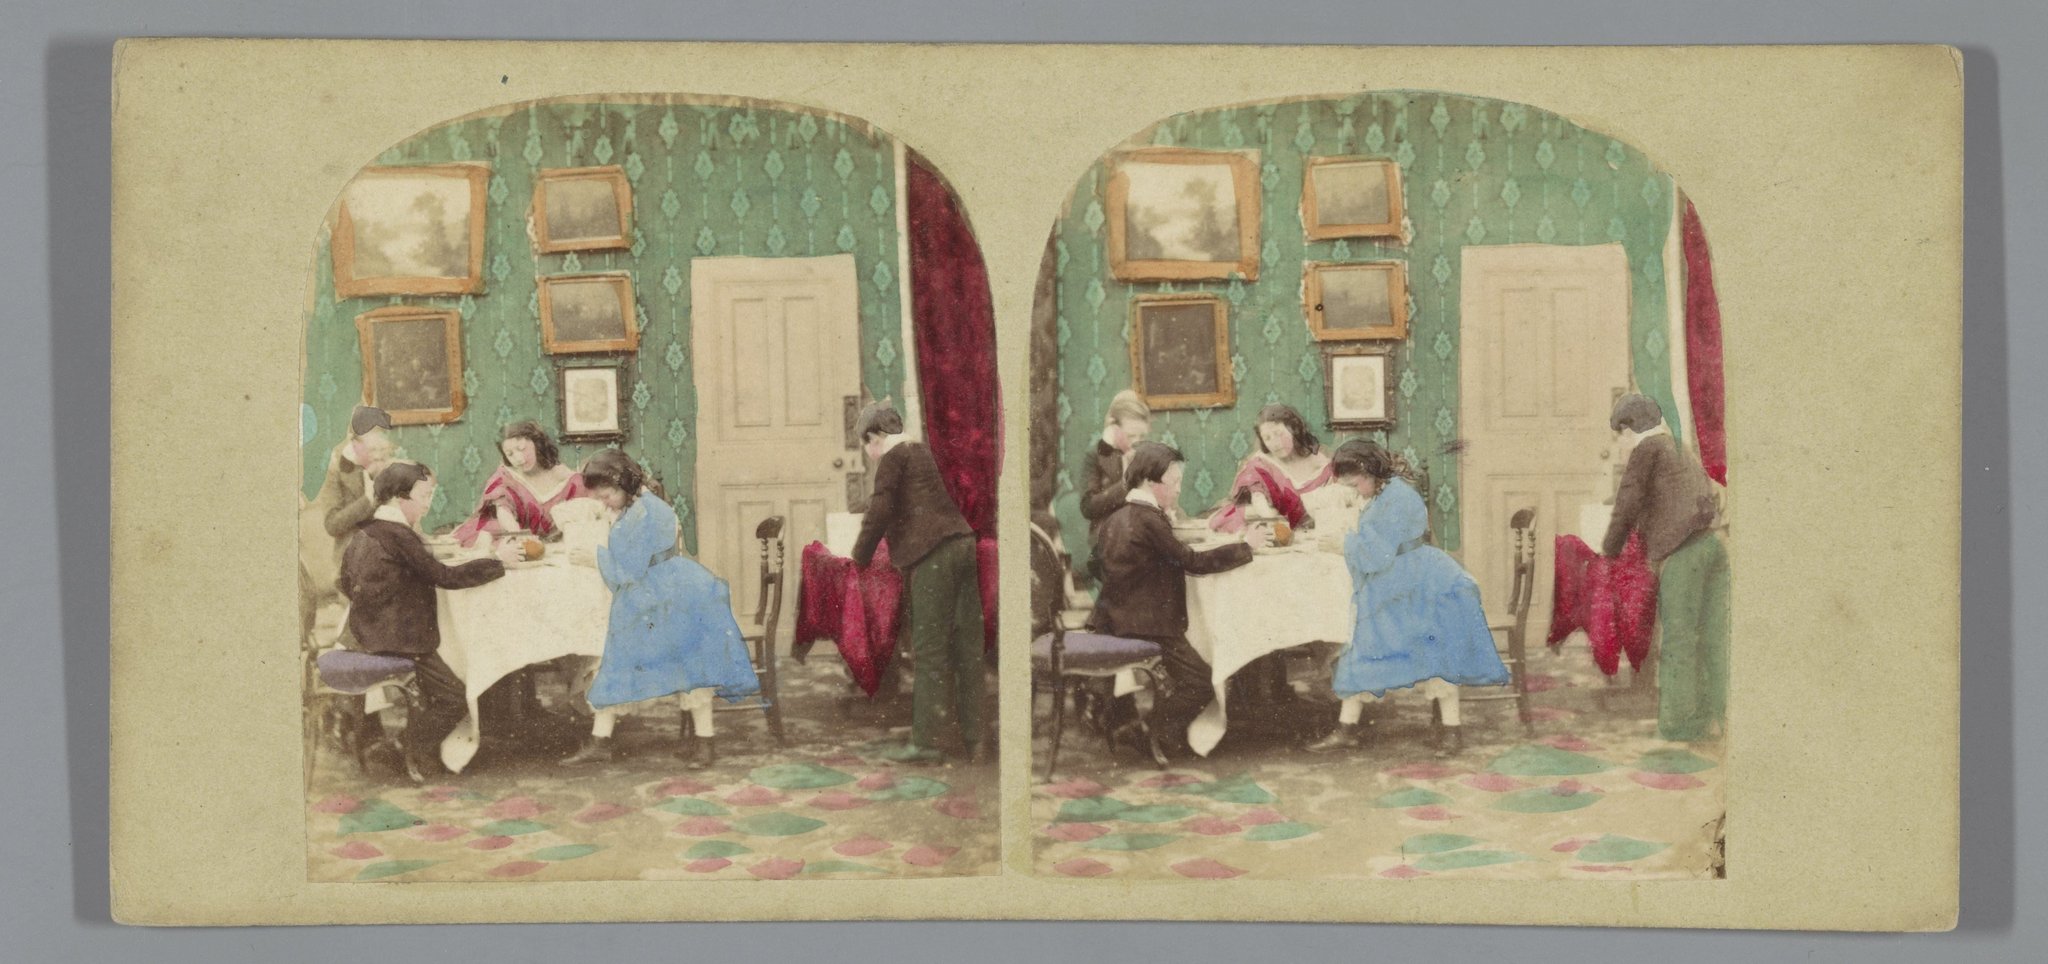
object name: stereograph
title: Kinderen rond een tafel in een huiskamer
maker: Anonymous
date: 1852-1863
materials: cardboard, paper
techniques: albumen print, hand coloring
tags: dining-room, child (at home)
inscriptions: inscription: ‘2.50’